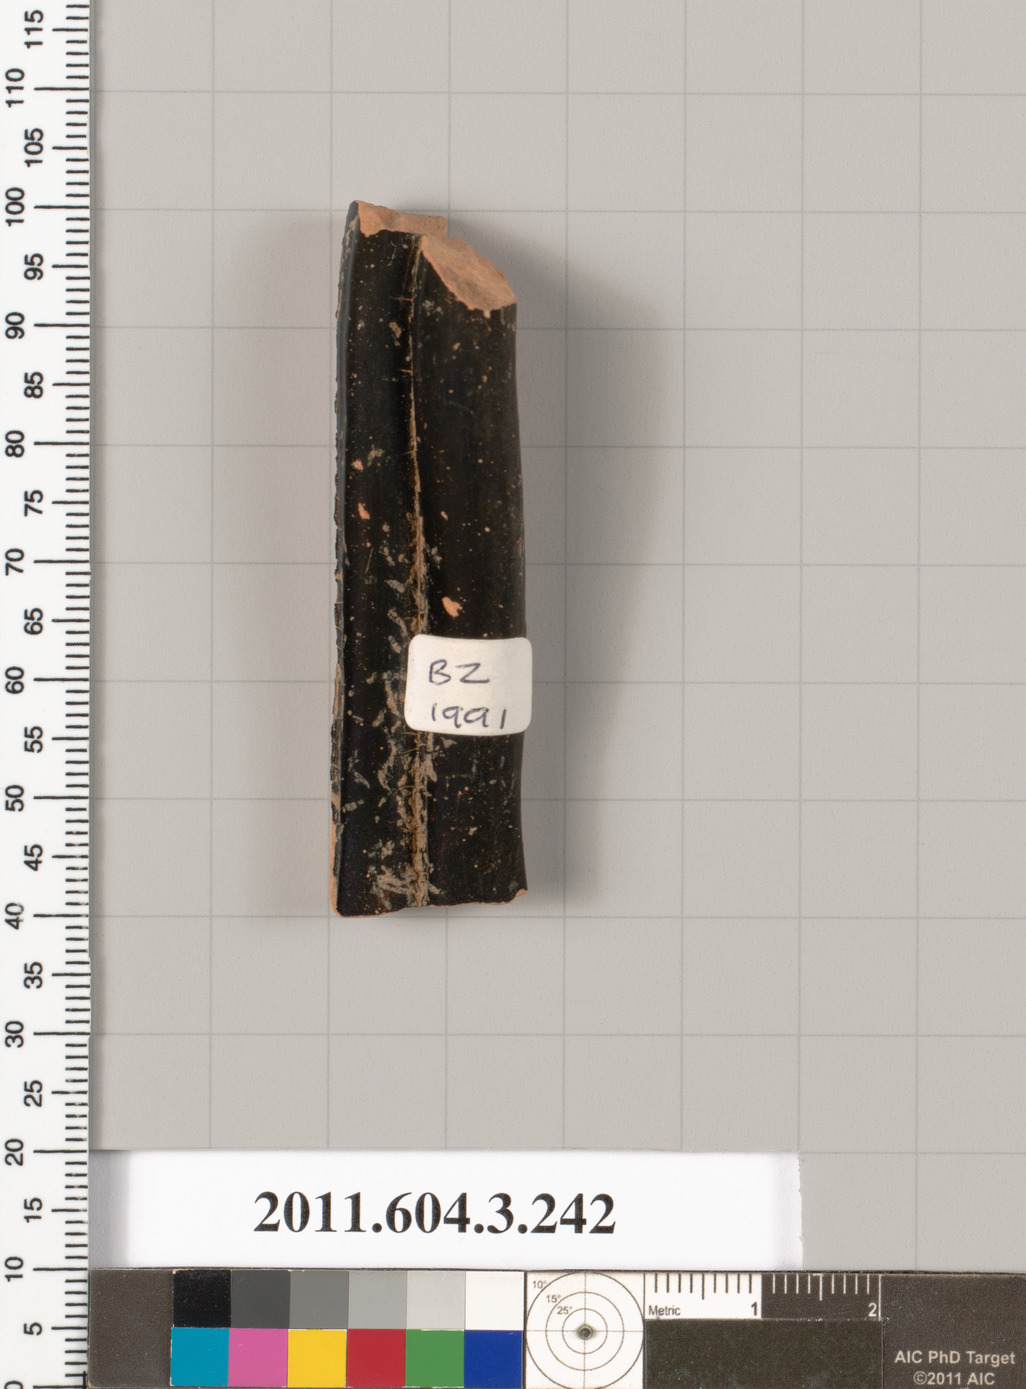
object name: neck amphora fragment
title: Terracotta fragment of a neck-amphora (jar)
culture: greek, attic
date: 534-468 BCE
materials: terracotta